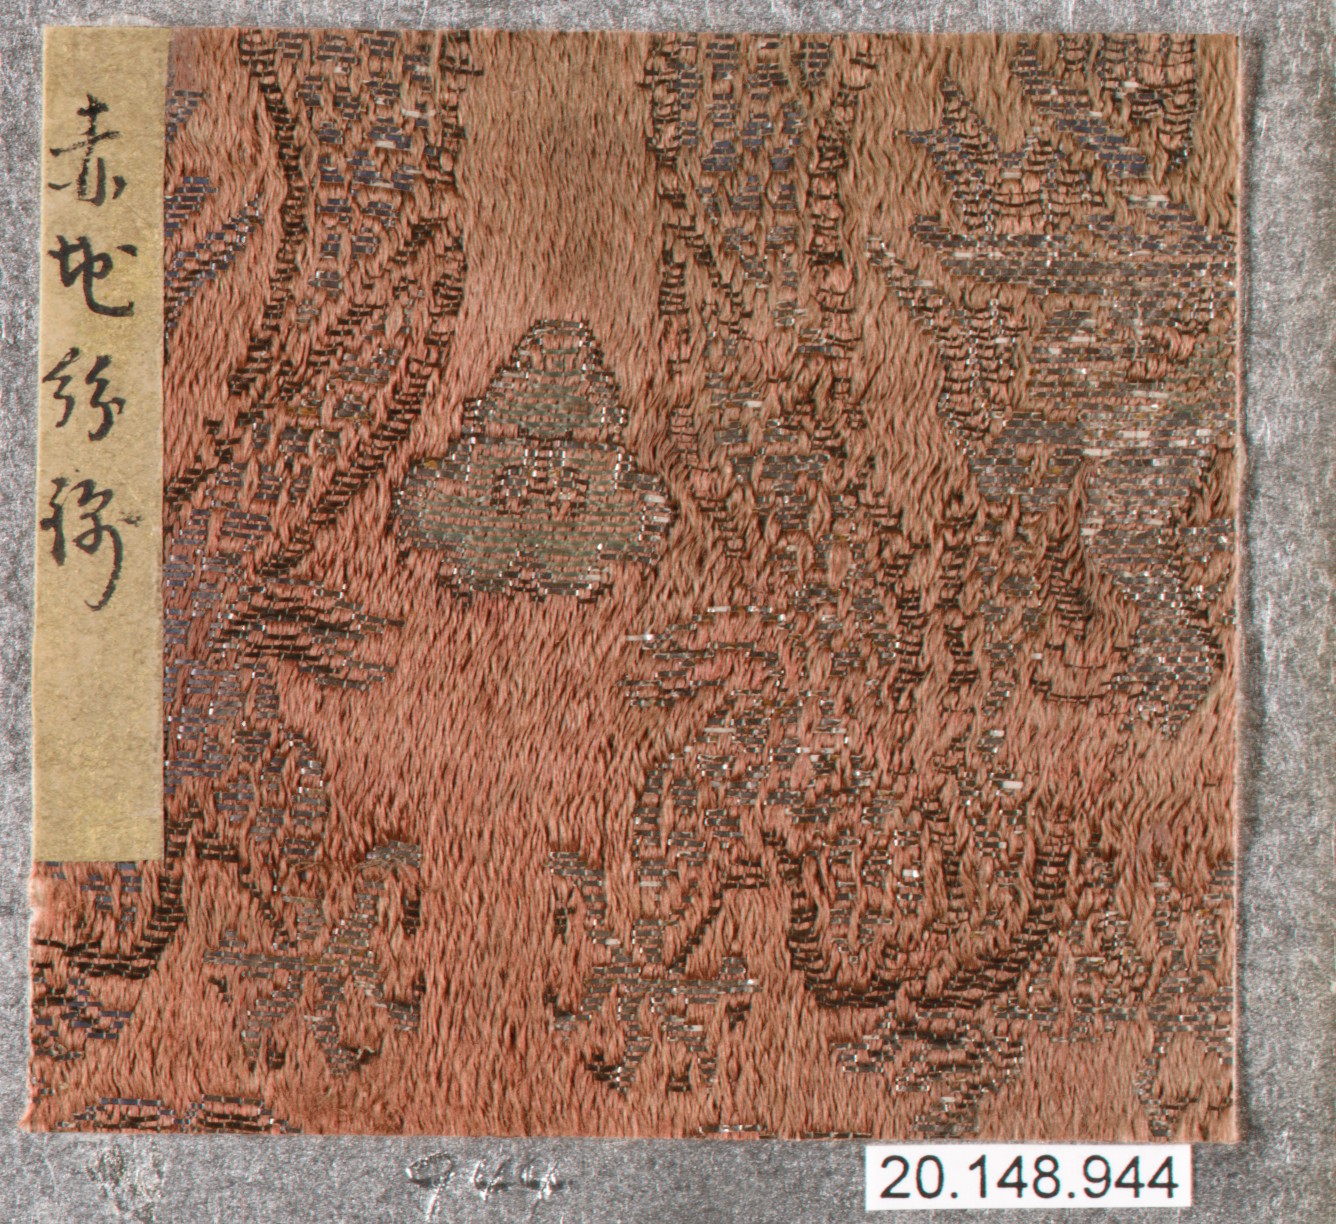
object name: piece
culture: china or japan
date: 1601-1700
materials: silk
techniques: compound weave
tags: dragons